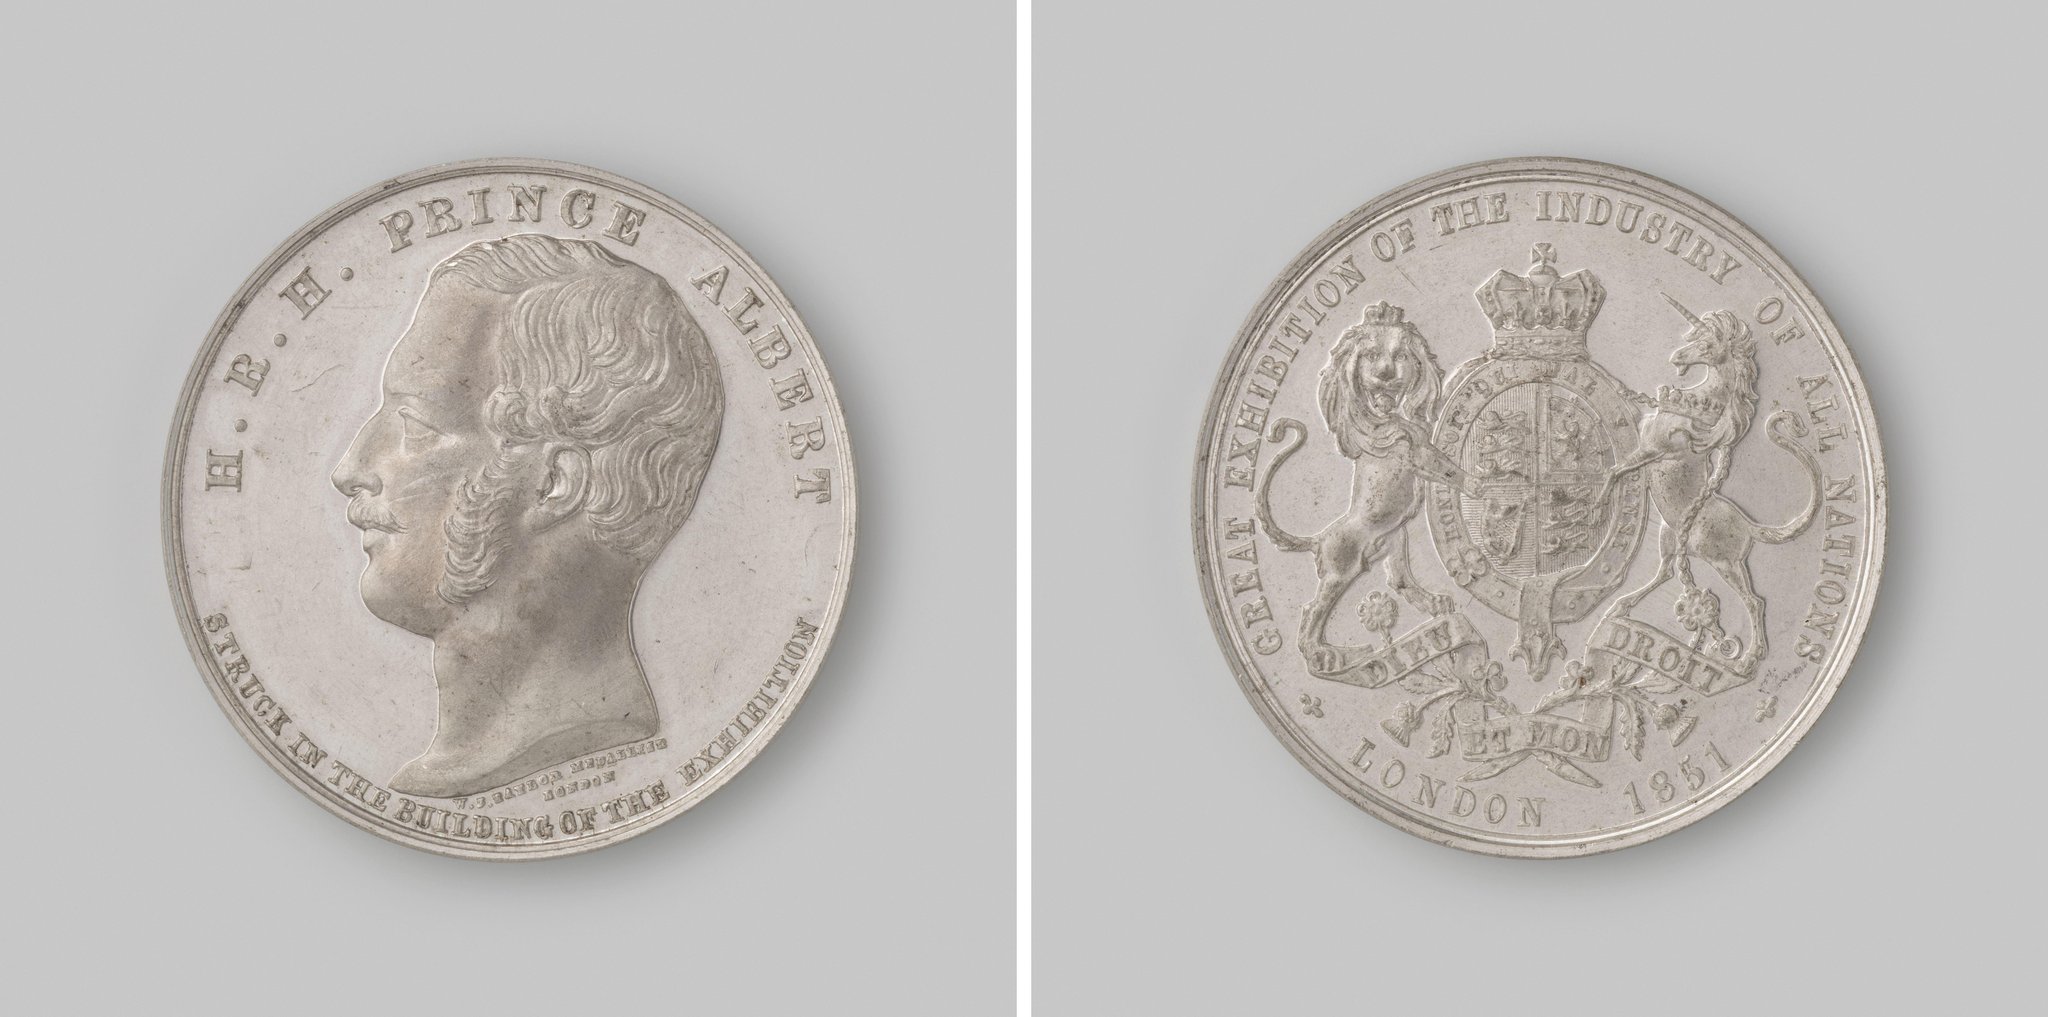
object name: history medal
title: Internationale Tentoonstelling te Londen 1851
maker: william joseph taylor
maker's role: medailleur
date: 1851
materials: tin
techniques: striking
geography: london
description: Tinnen penning, op de voorzijde het portret van Prins Albert naar links met omschrift, op de keerzijde het gekroonde ovalen Engelse wapenschild met dragers op spreukband, met omschrift.